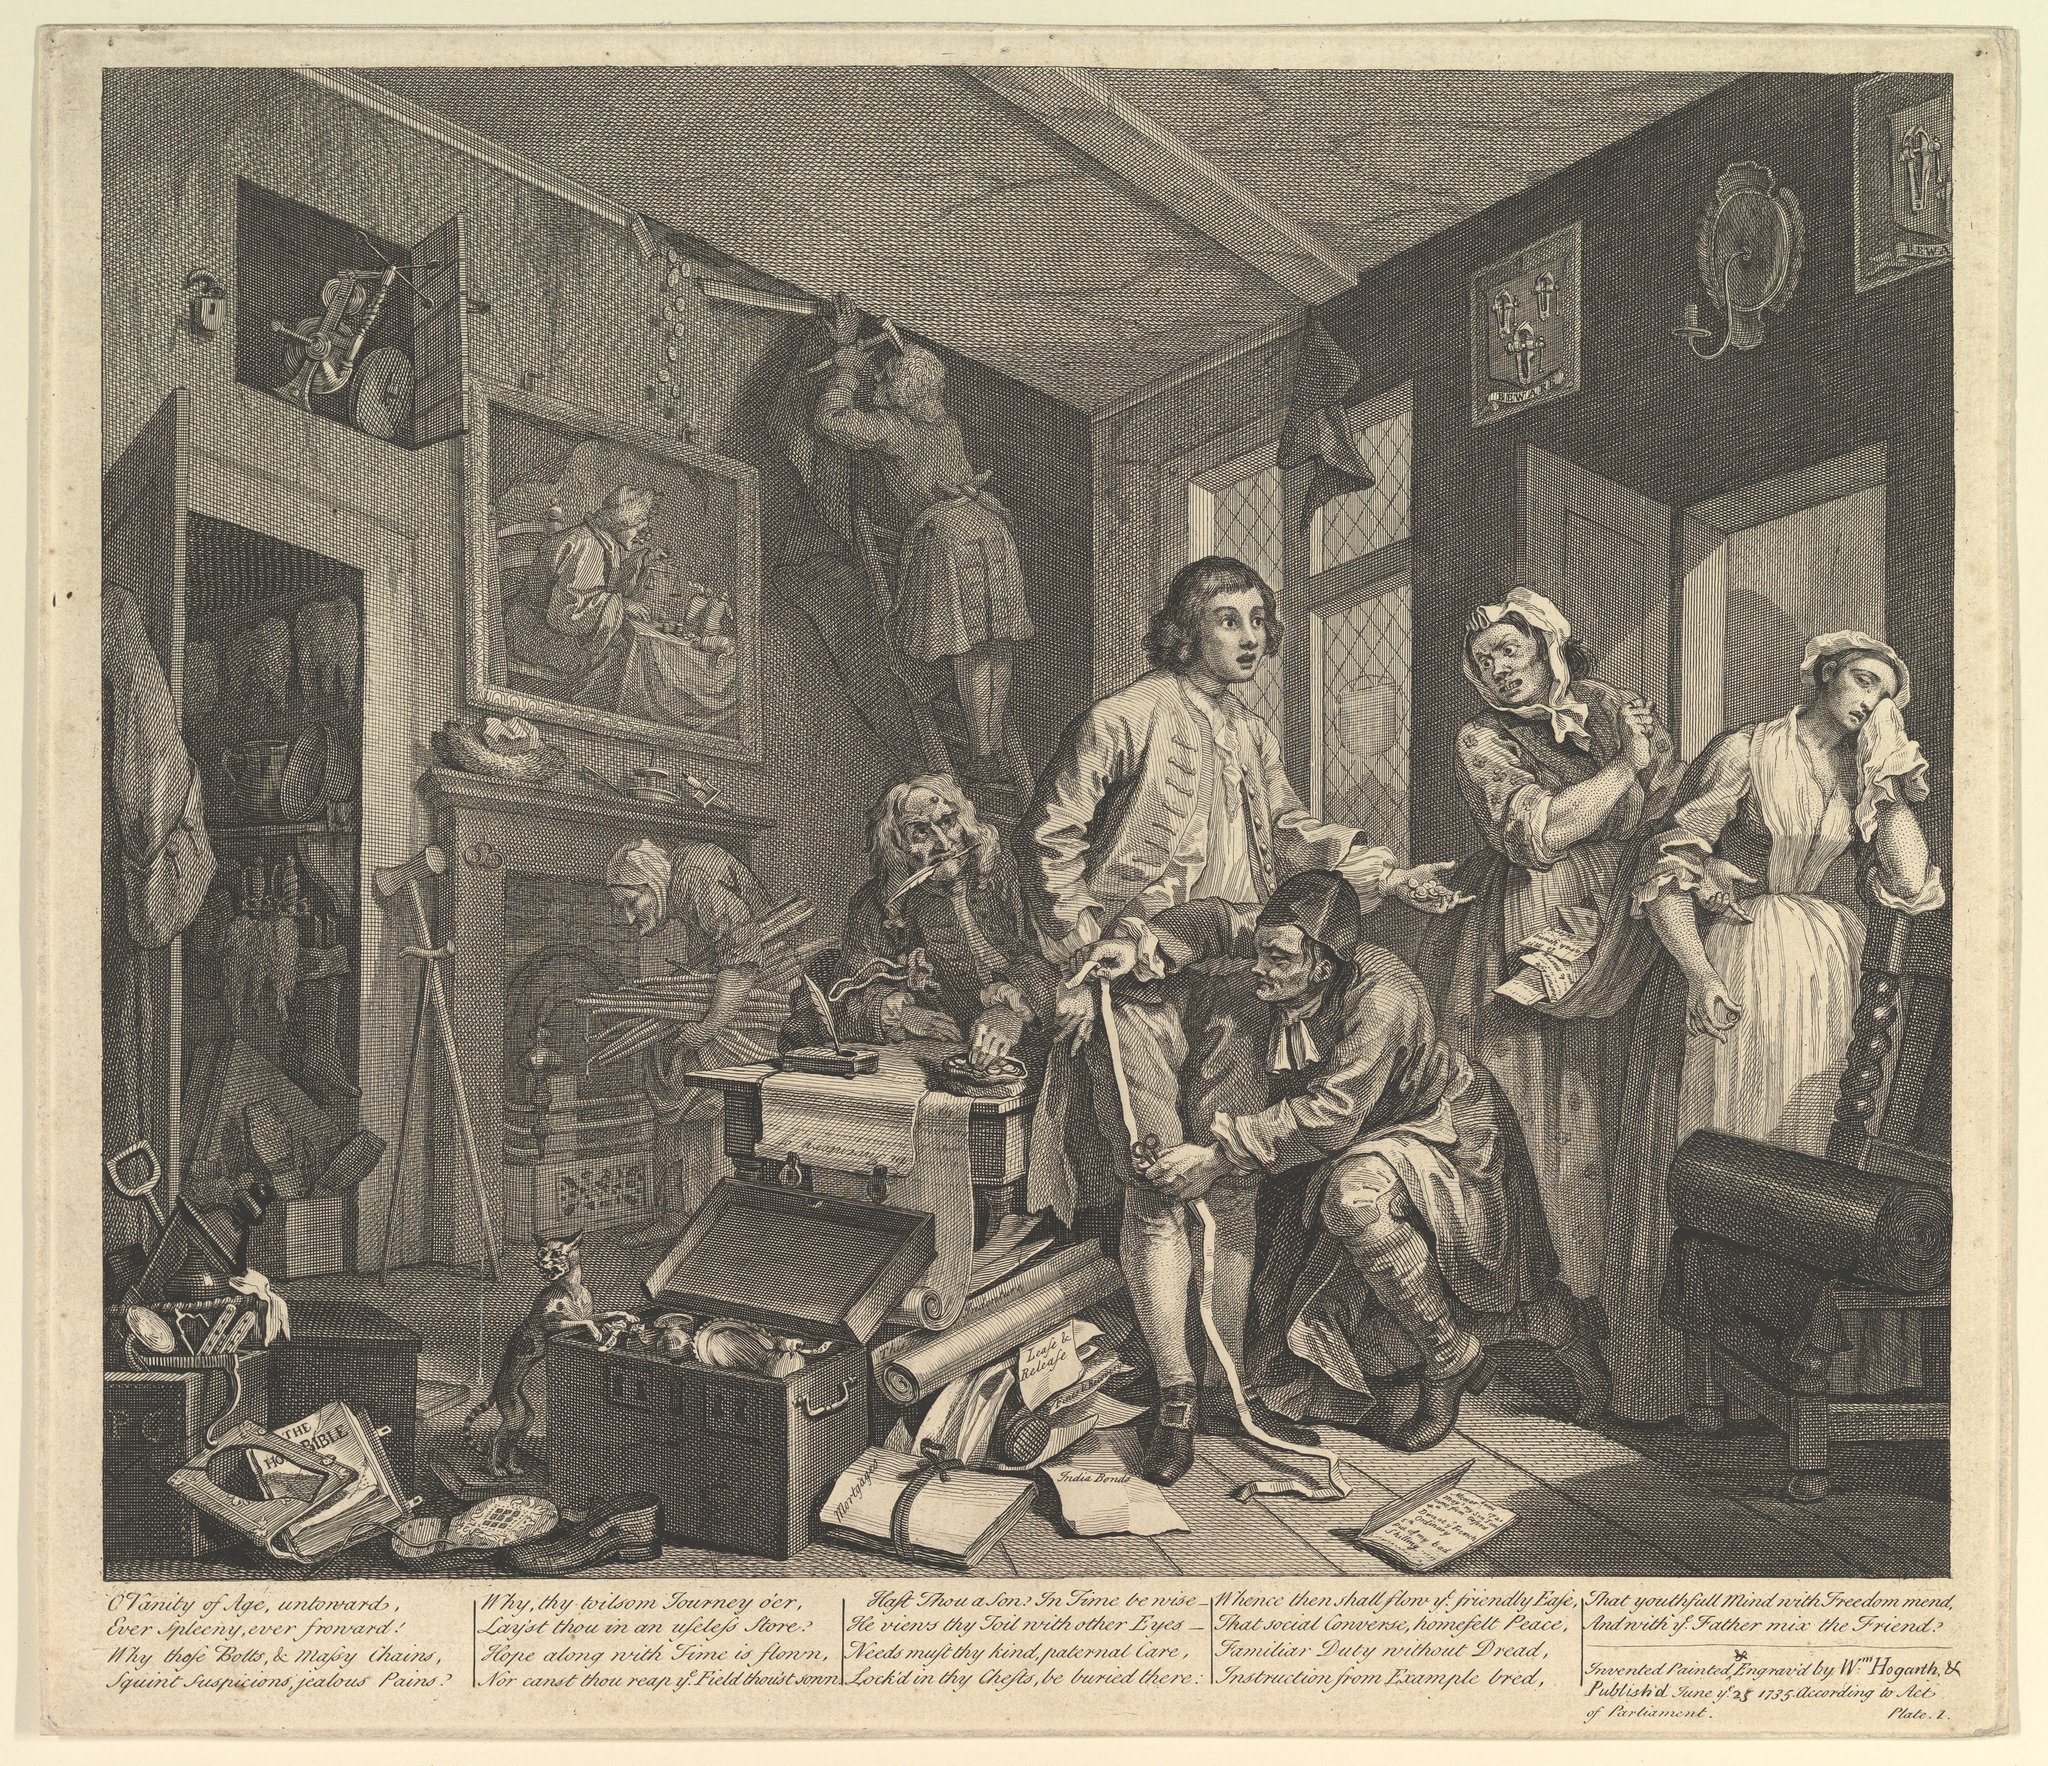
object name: print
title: A Rake's Progress, Plate 1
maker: william hogarth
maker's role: artist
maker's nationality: british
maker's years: 1697-1764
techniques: engraving, etching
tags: interiors,men,women,working